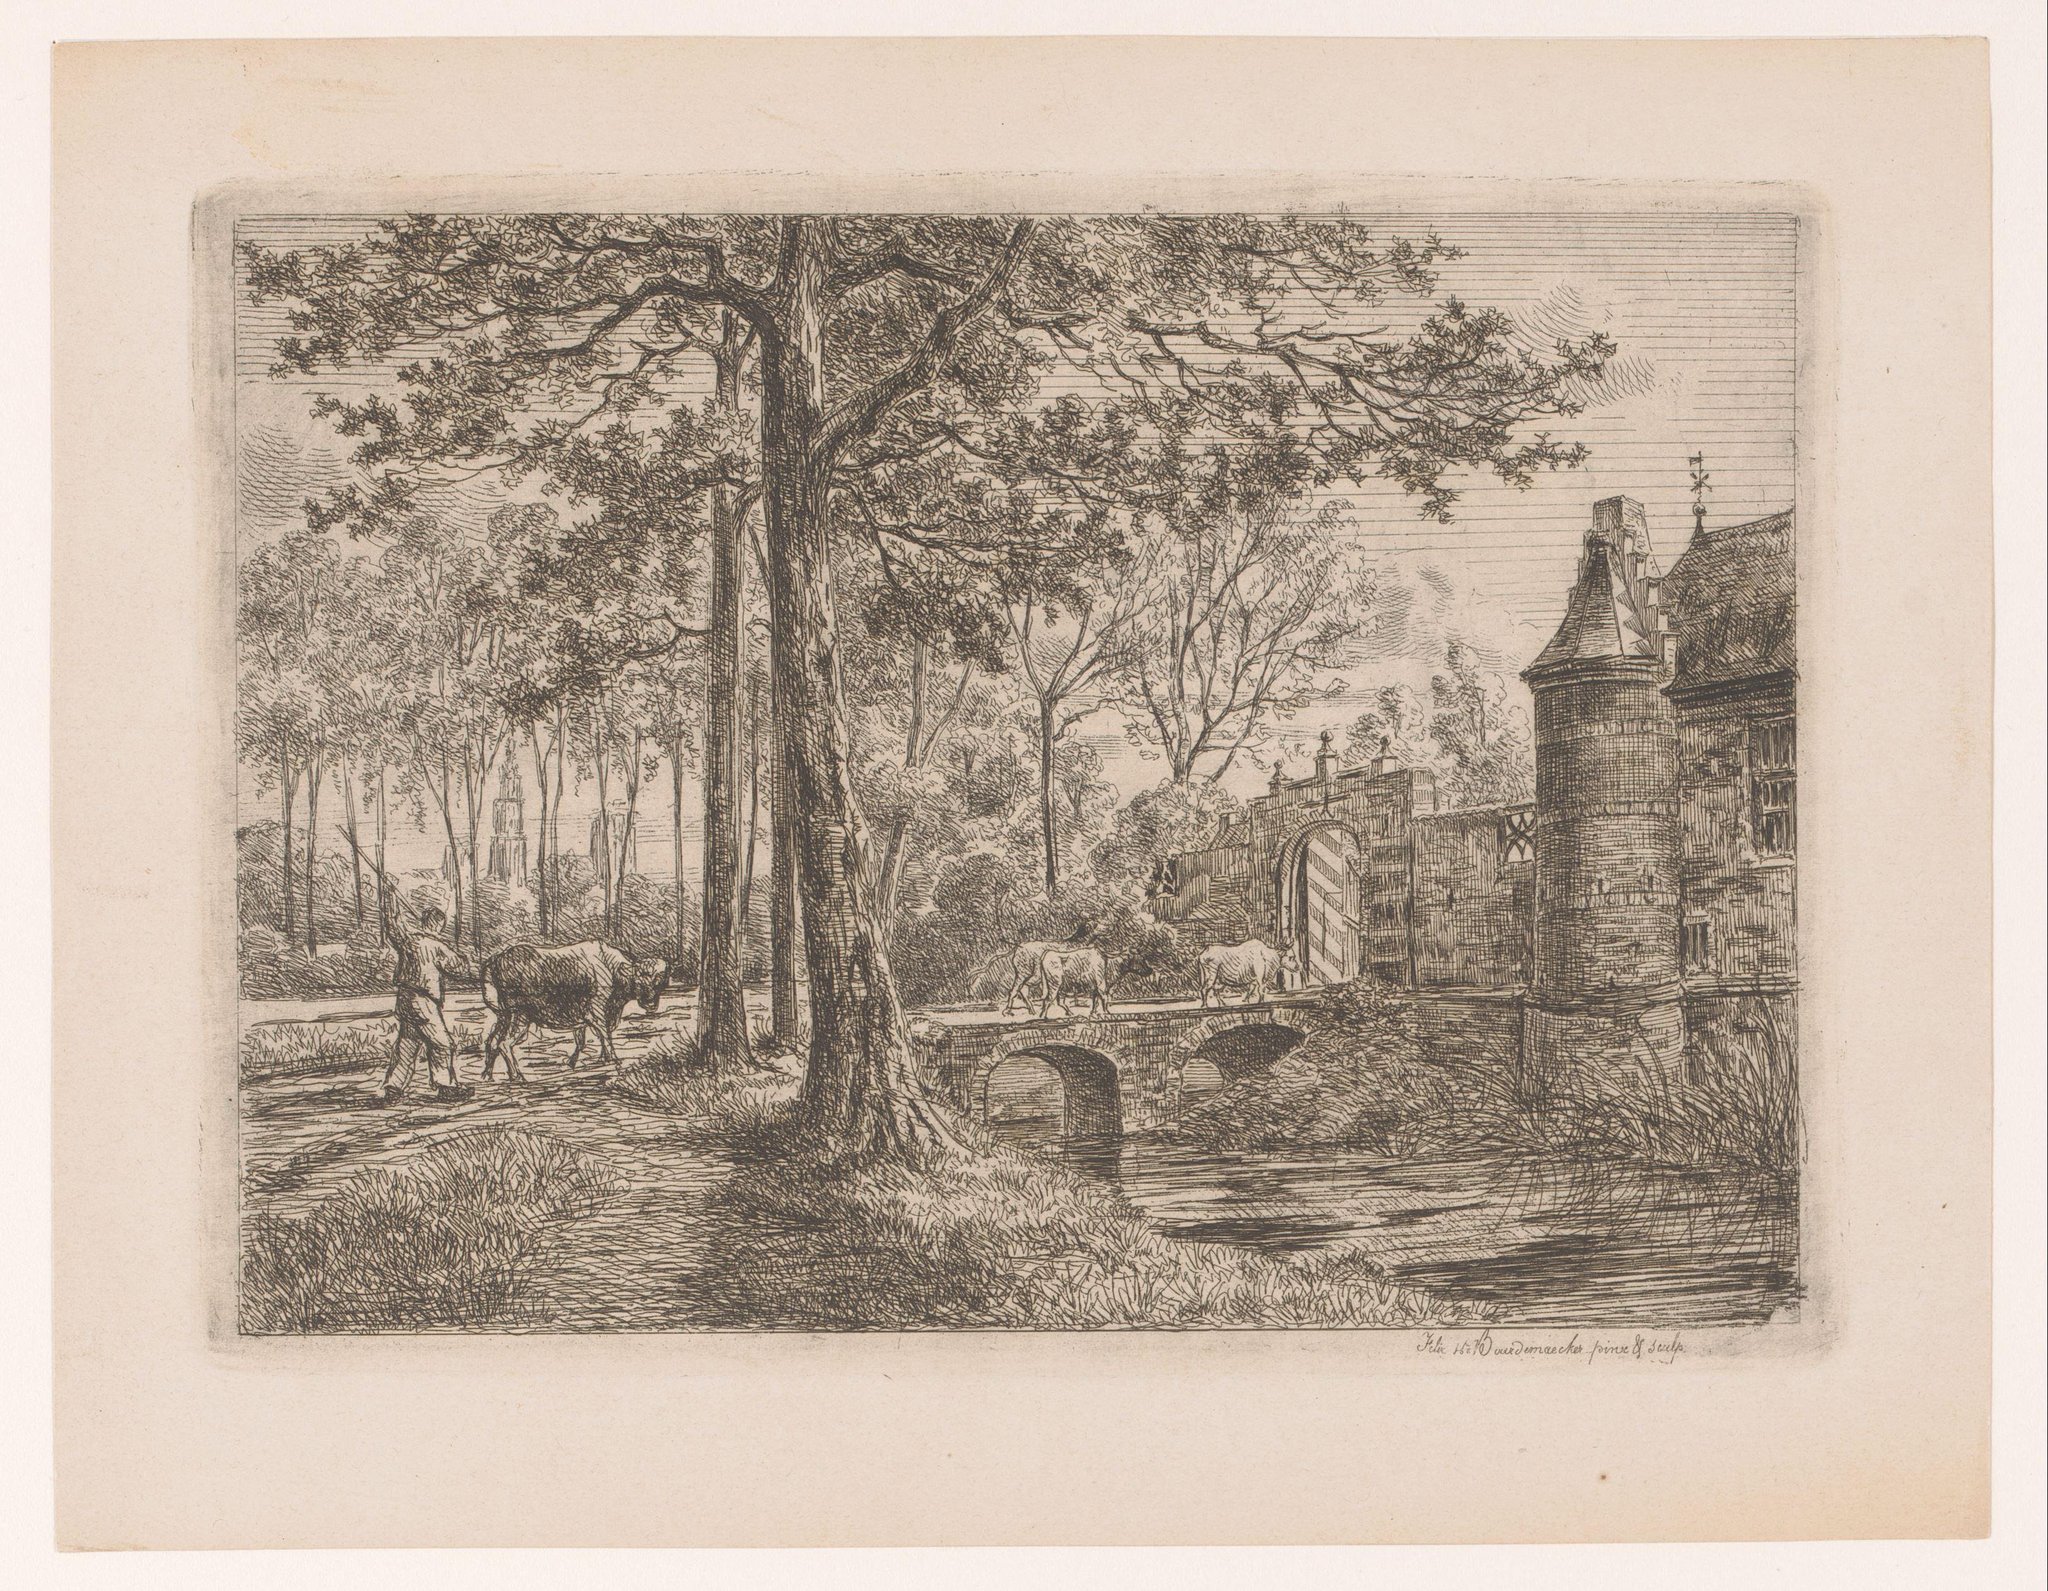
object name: print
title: Gezicht op Kasteel Sterckshof in Deurne bij Antwerpen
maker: félix de baerdemaecker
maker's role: print maker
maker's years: 1836-1878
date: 1846-1878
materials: paper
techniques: etching, letterpress printing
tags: castle, landscape with tower or castle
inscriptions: collector's mark: Lugt 2228